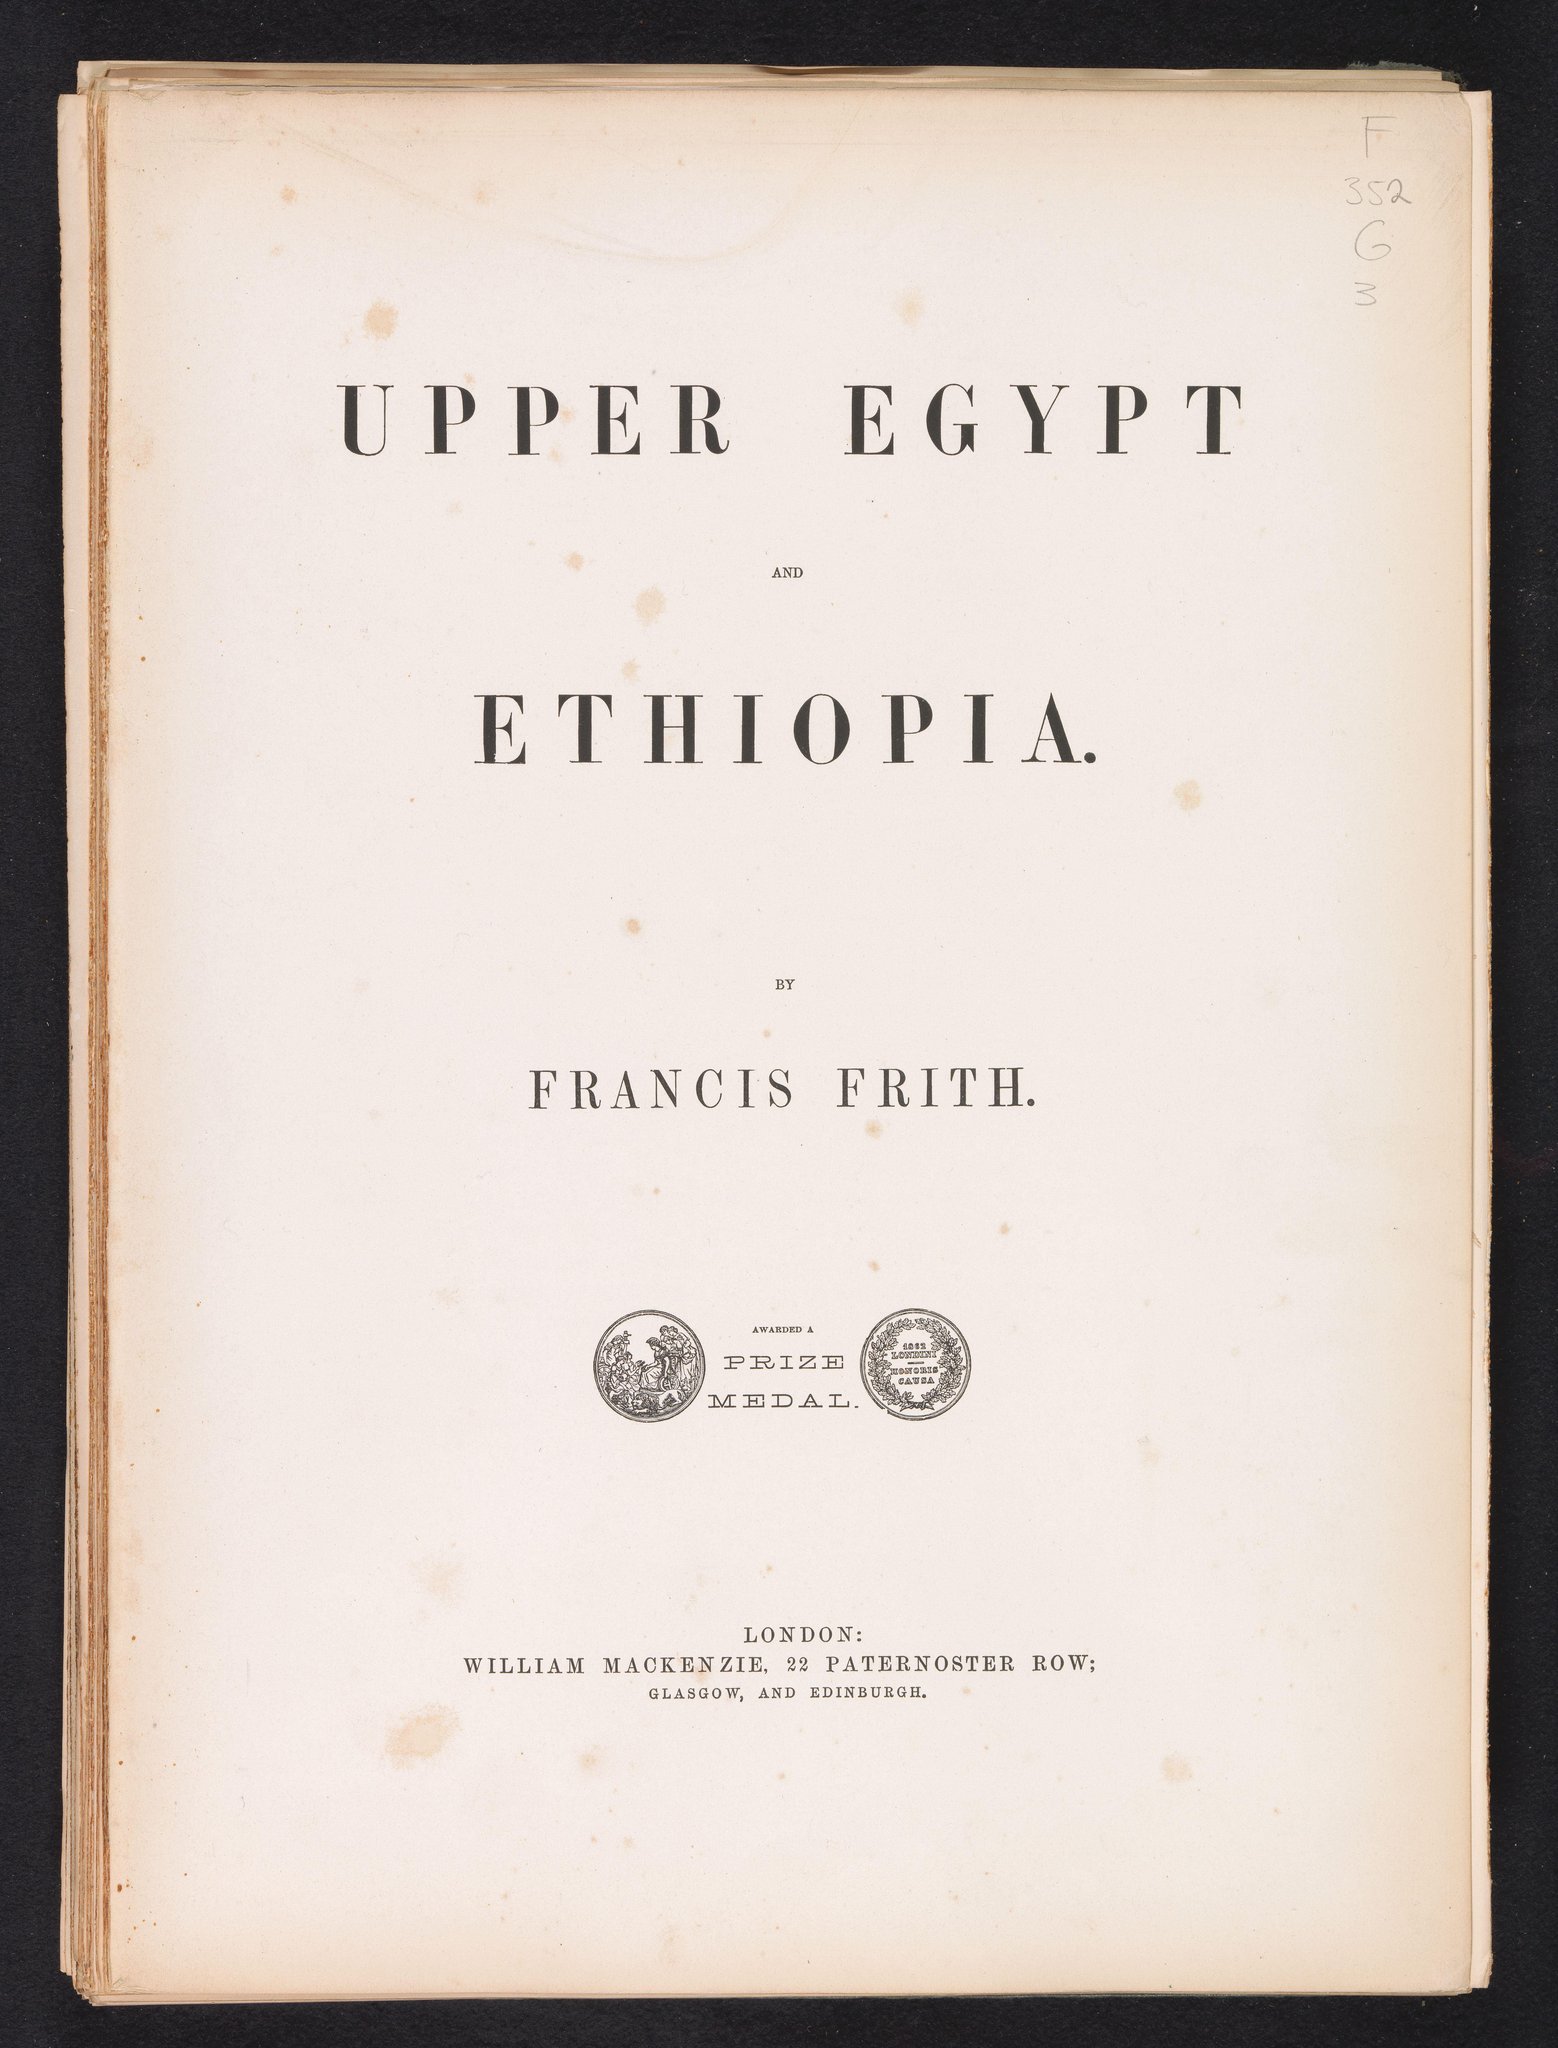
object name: book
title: Upper Egypt and Ethiopia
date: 1862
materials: cardboard, leather, linen, paper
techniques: albumen print, letterpress printing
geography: london